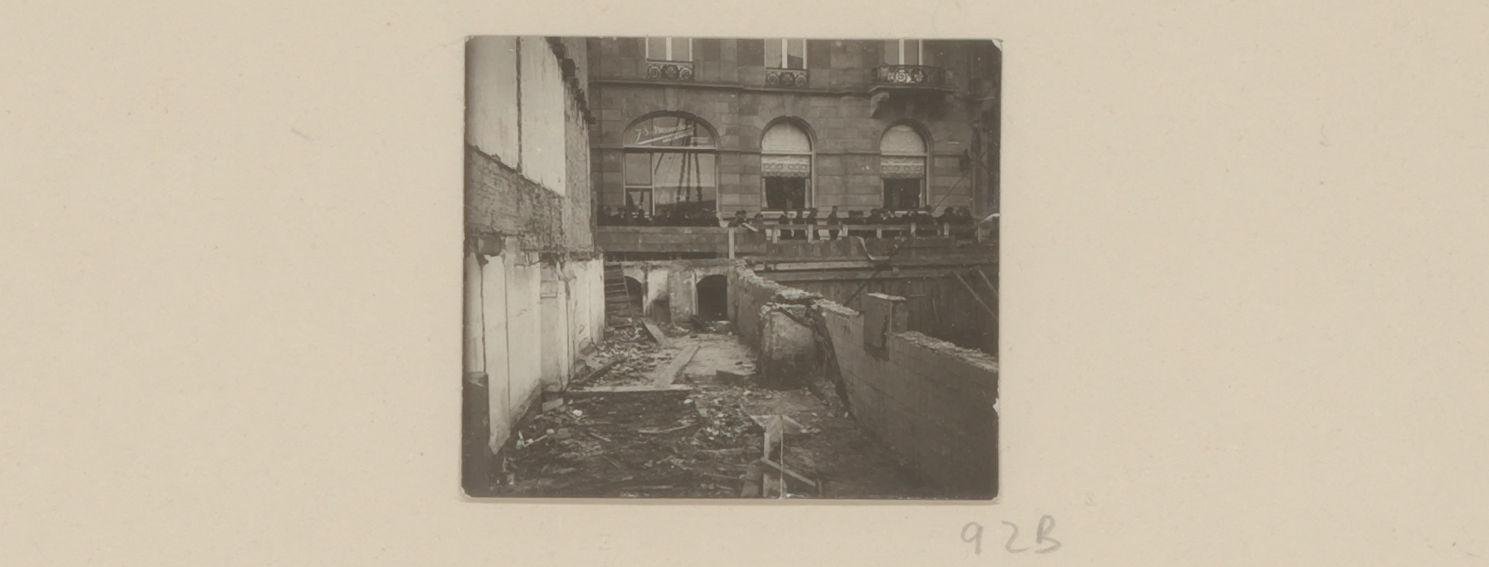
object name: photograph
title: Gezicht op de sloop van het pand van de juwelier Roelof Citroen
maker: Anonymous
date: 1880-1917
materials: paper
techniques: gelatin silver print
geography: amsterdam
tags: city-view in general; 'veduta', jeweller, goldsmith, silversmith, demolition of building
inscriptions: collector's mark: ‘9,2’ Lugt 1641b, inscription: ‘Geschenk v/d Heer Roelof Citroen / Aanwinst 1917’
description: Onderwerpsrubriek binnen de Atlas Amsterdam: Kadijksplein, Karthuizerkerkhof, Kattegat, Kattenburg, Kapelsteeg O.Z., Enge Kerksteeg, Kerkstraat, Kinkerstraat, Kolk O.Z., Koningsplein, Kromboomsloot [Krom Boomssloot], Kostverlorenkade, Kwakersdwarspad, Kalverstraat, Keizersgracht (v.d. Brouwersgracht – Amstel), Klerensloot (Gedempte), Klimopstraat, Kloveniersburgwal, Kraansluis.